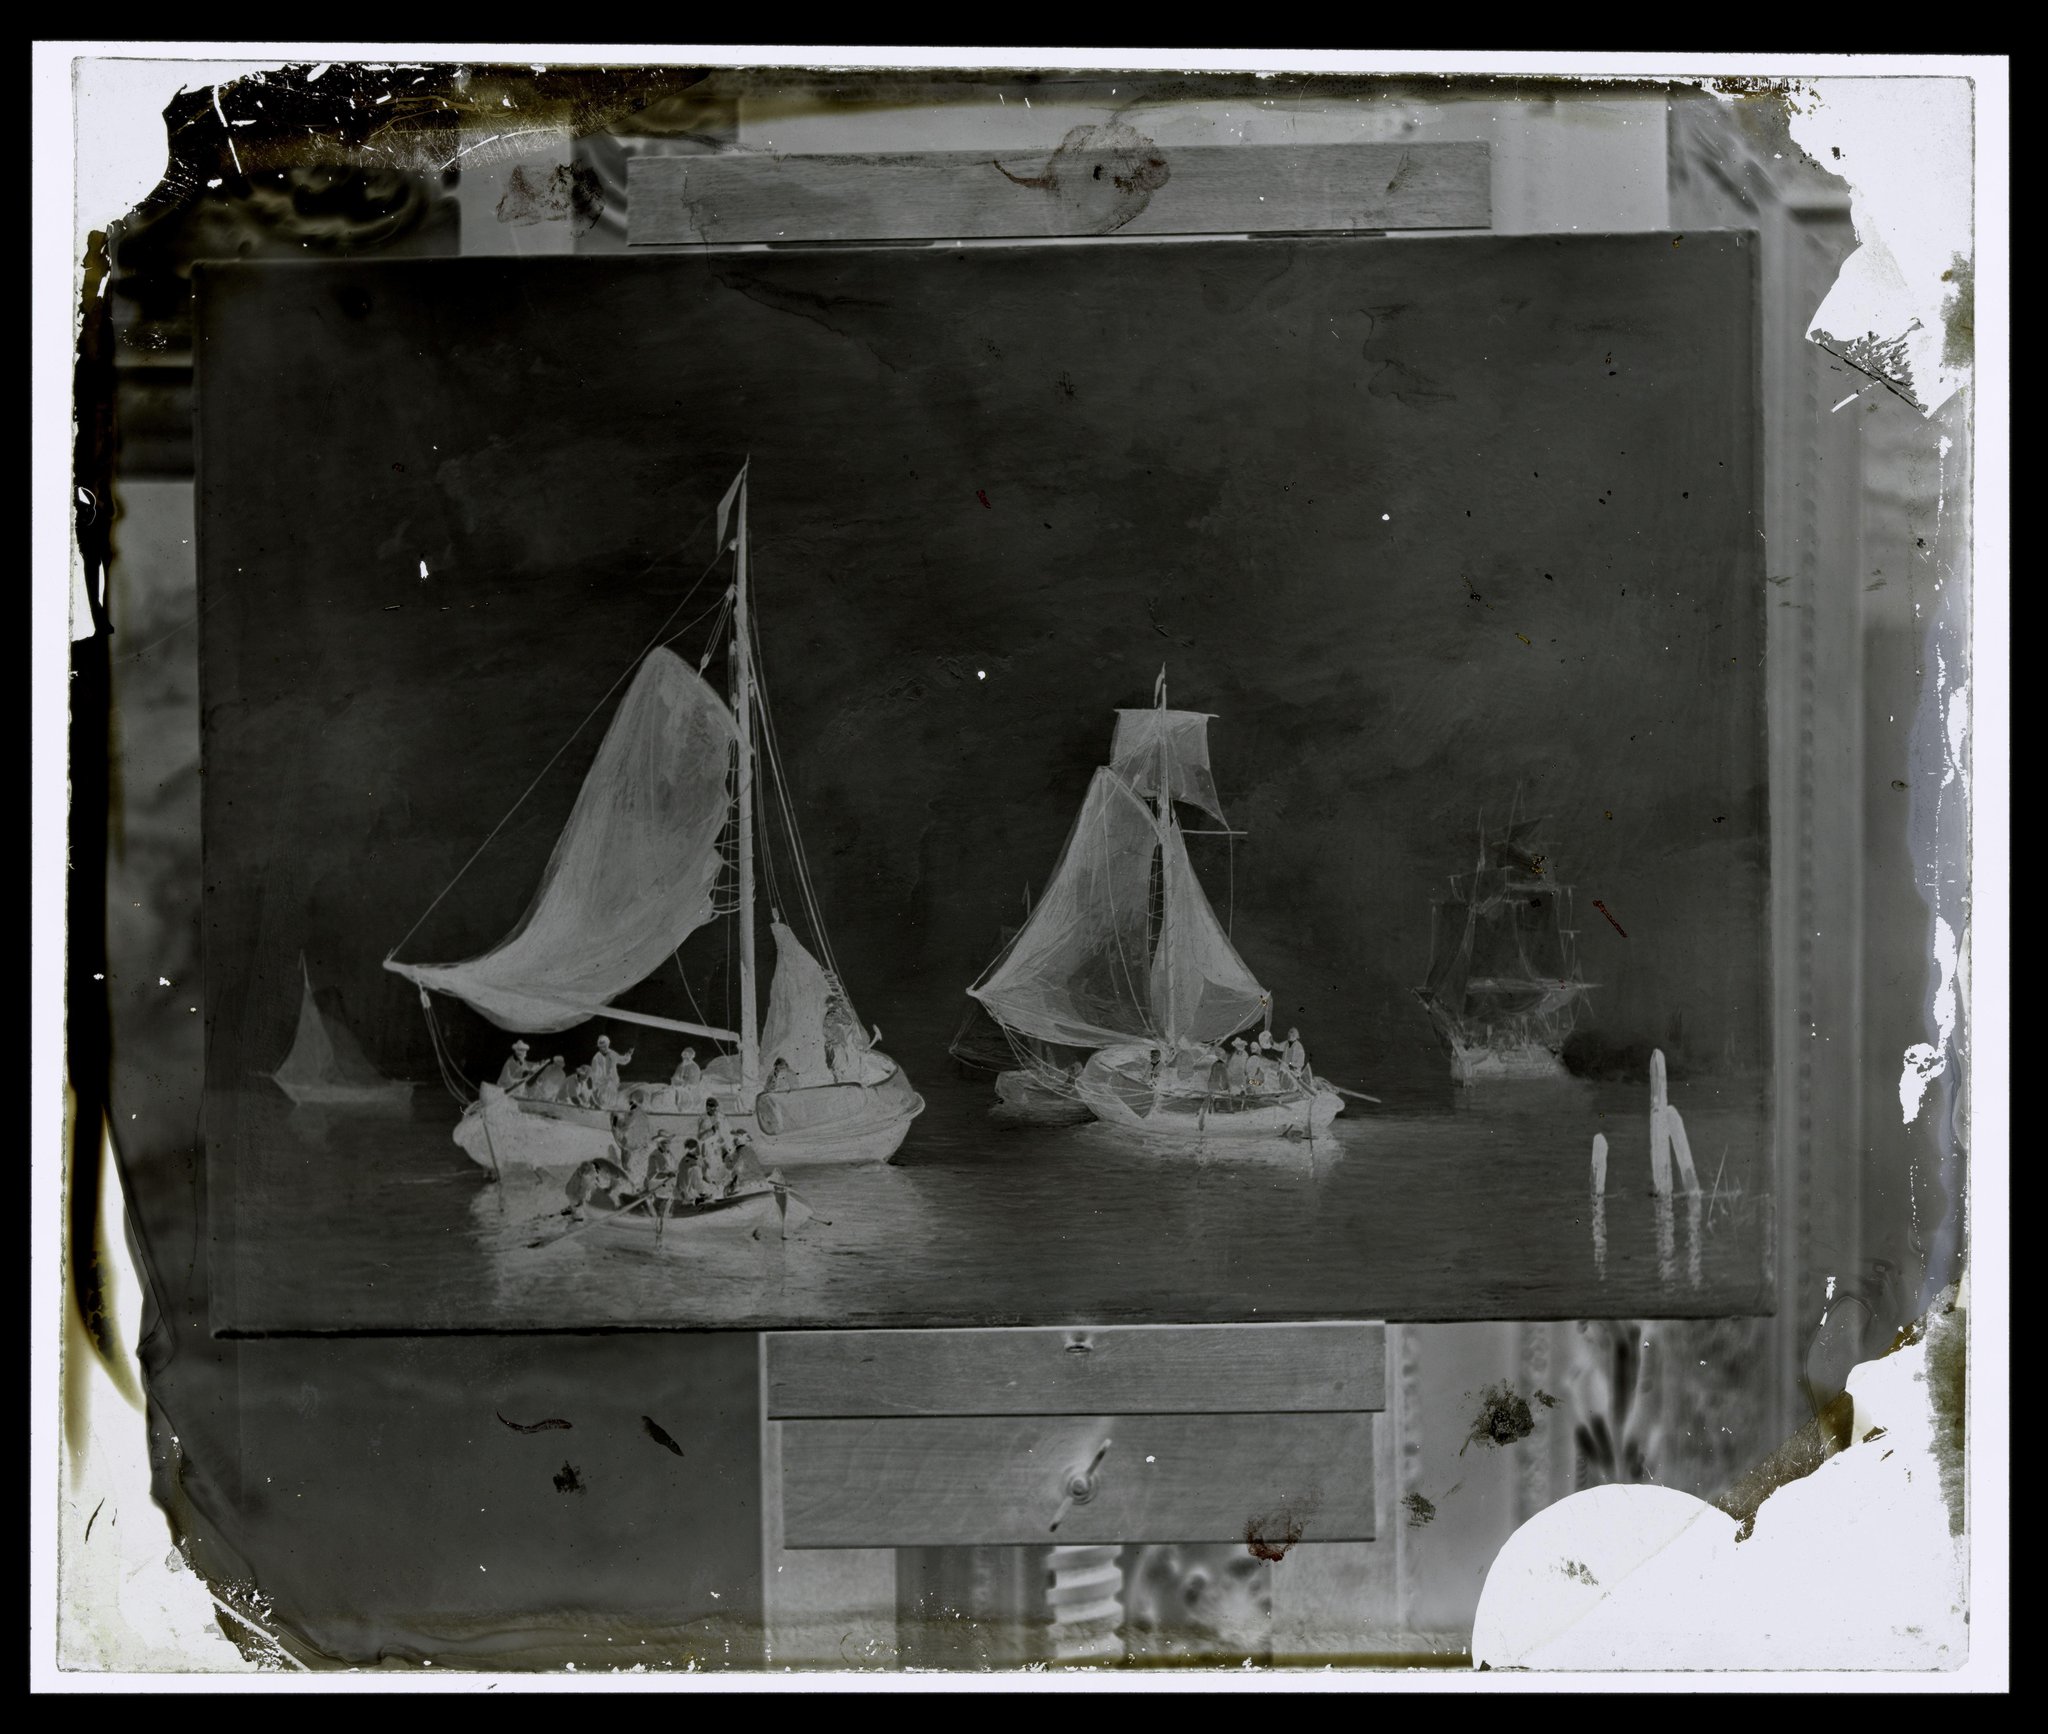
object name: glasnegatief, glasplaatnegatief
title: Fotoreproductie van een schilderij van zeilschepen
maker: laurens lodewijk kleijn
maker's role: draughtsman, painter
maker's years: 1826-1909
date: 1865-1900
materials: glass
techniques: collodion process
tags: ships (in general) - cc - more than one ship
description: Onderdeel van een groep glasnegatieven uit de nalatenschap van de schilder Laurens Lodewijk Kleijn, met stillevens, portretten, zelfportretten en kunstreproducties.